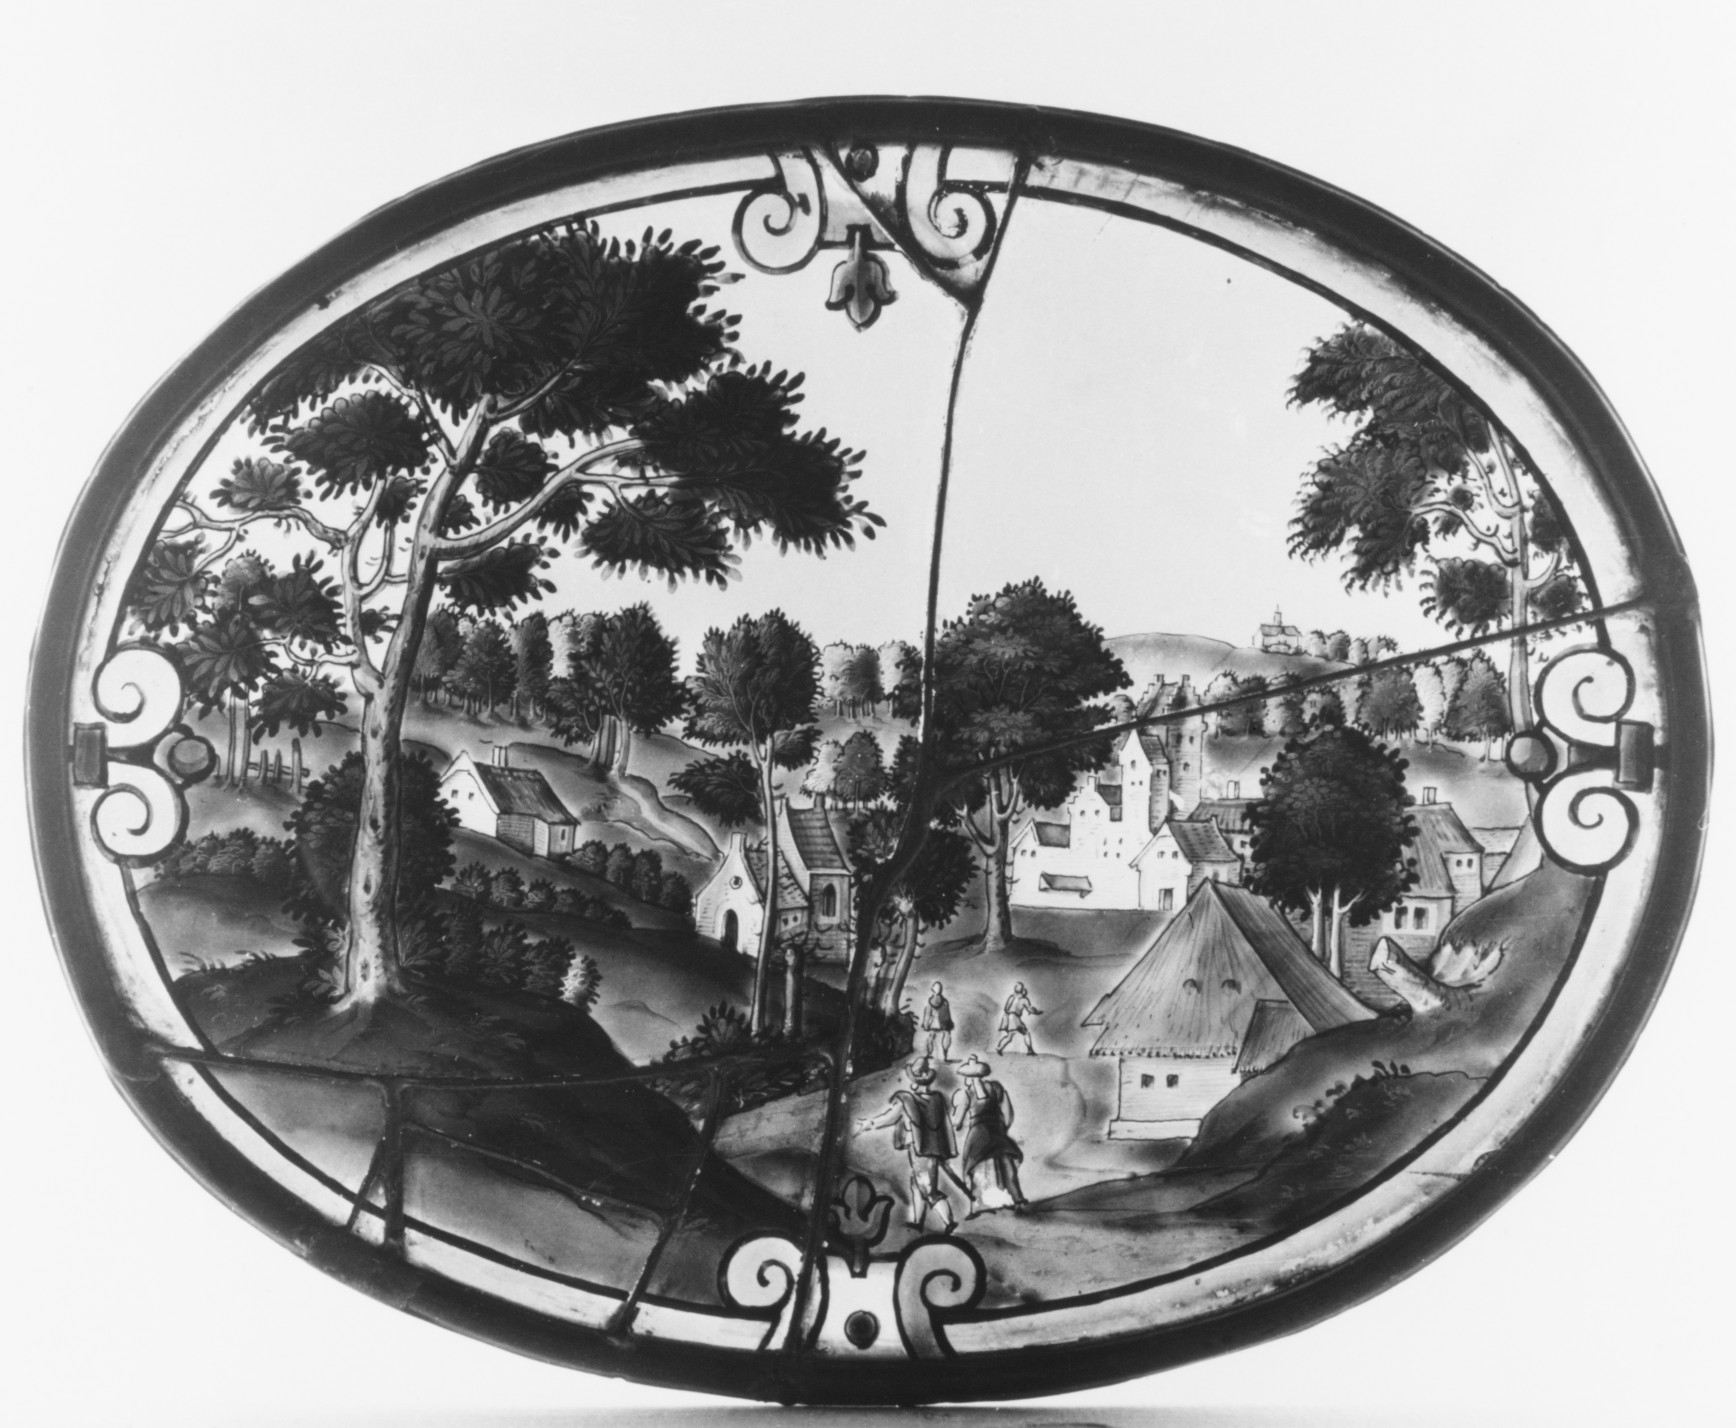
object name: panel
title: Landscape with view of a village (one of three)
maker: christoph murer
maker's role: maker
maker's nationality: swiss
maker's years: 1558-1614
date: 1601-1633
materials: glass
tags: villages,landscapes,trees